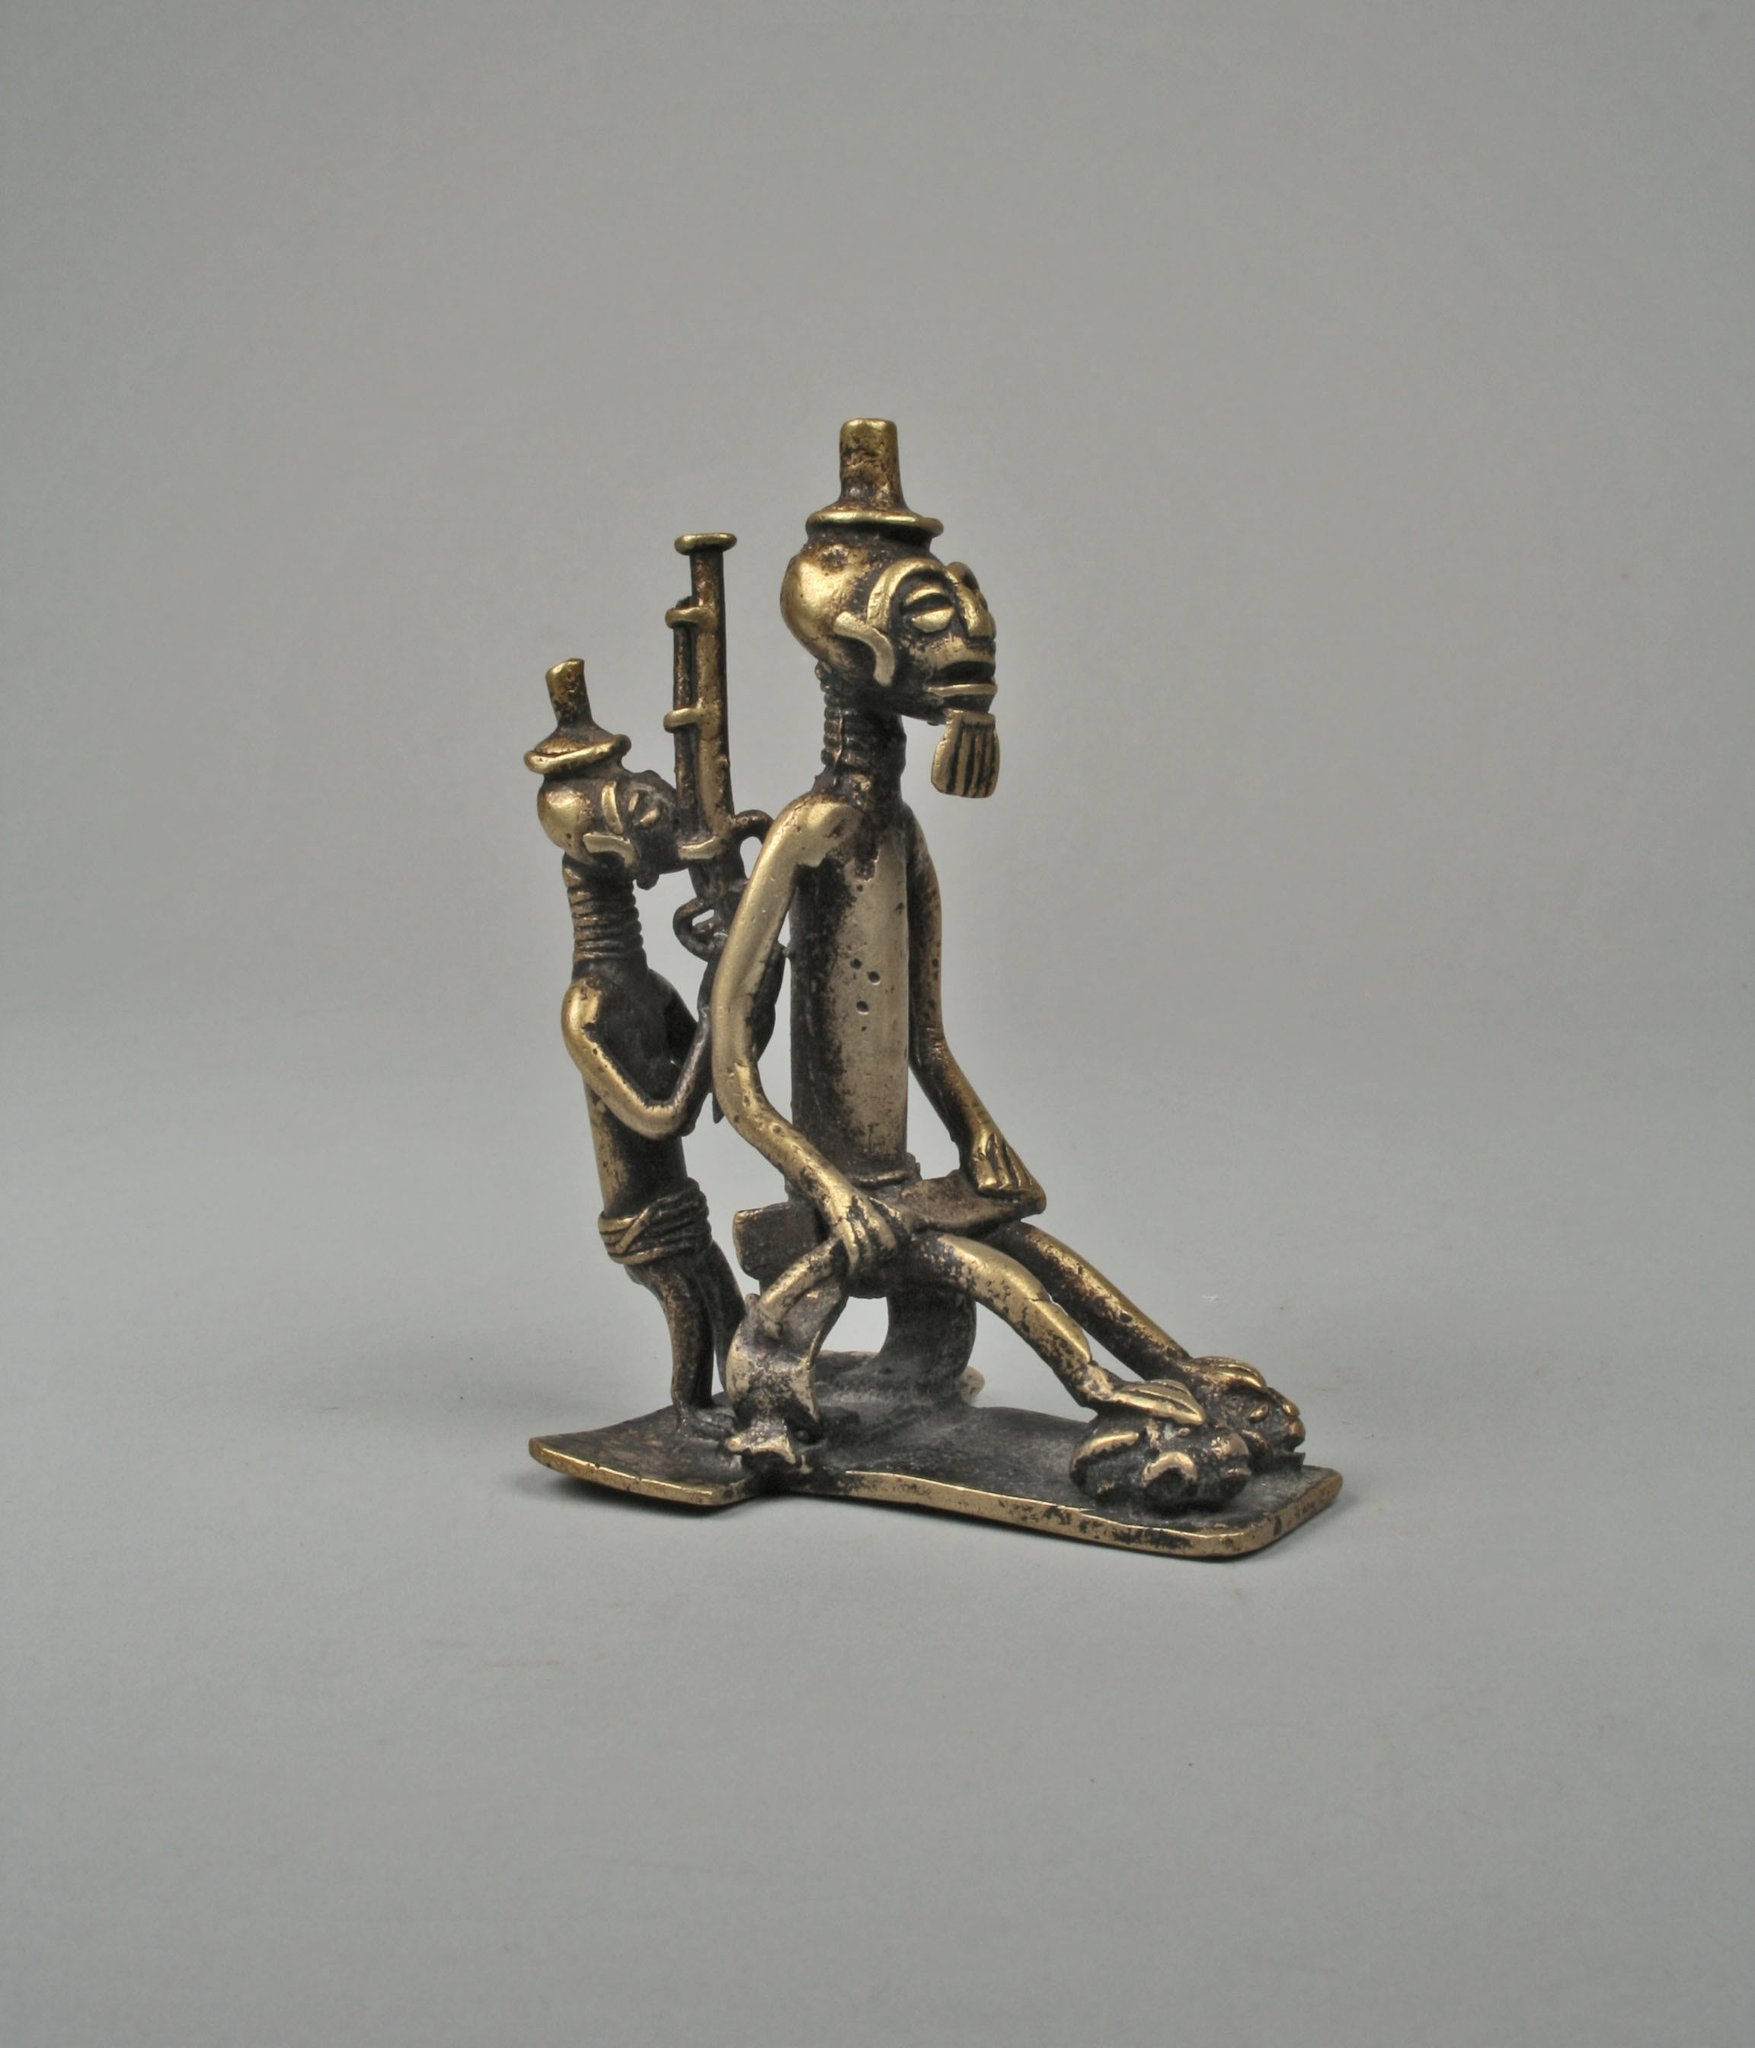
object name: weight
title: Gold Weight: Chief with Attendant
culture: yoruba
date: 1801-1900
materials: brass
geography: nigeria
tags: men